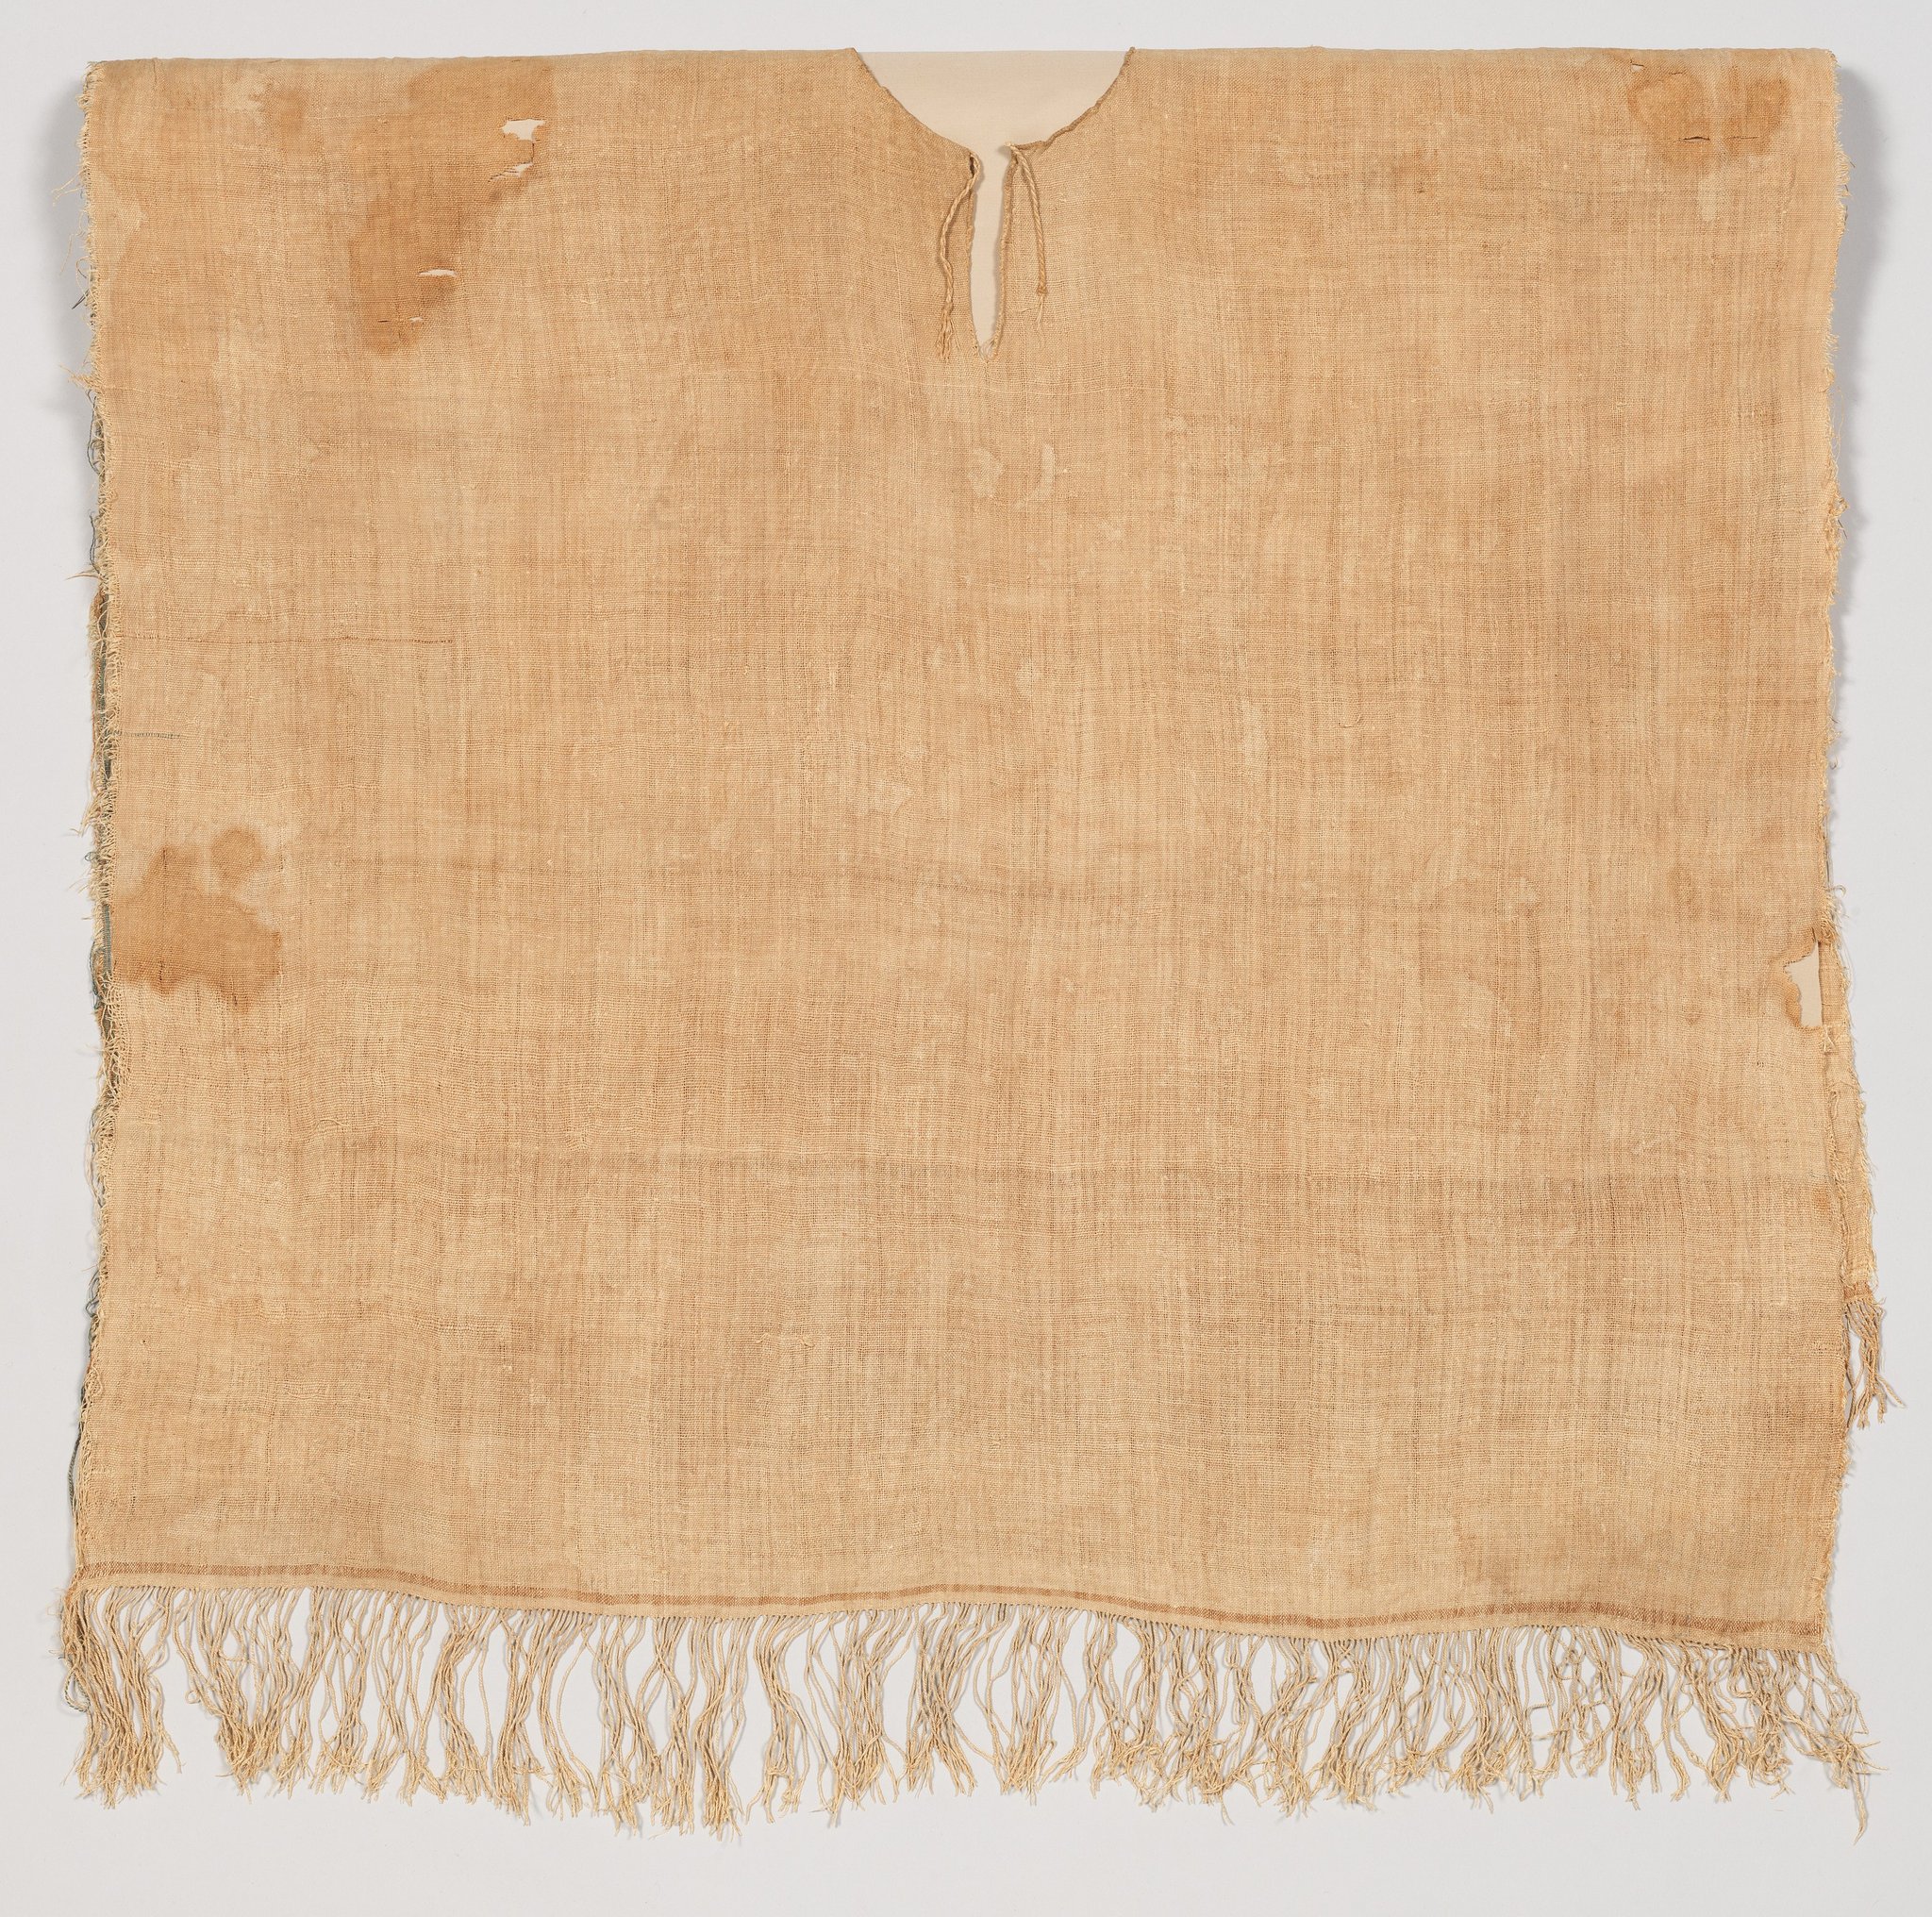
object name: shirt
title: Child's Shirt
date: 650-400 BCE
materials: linen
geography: egypt